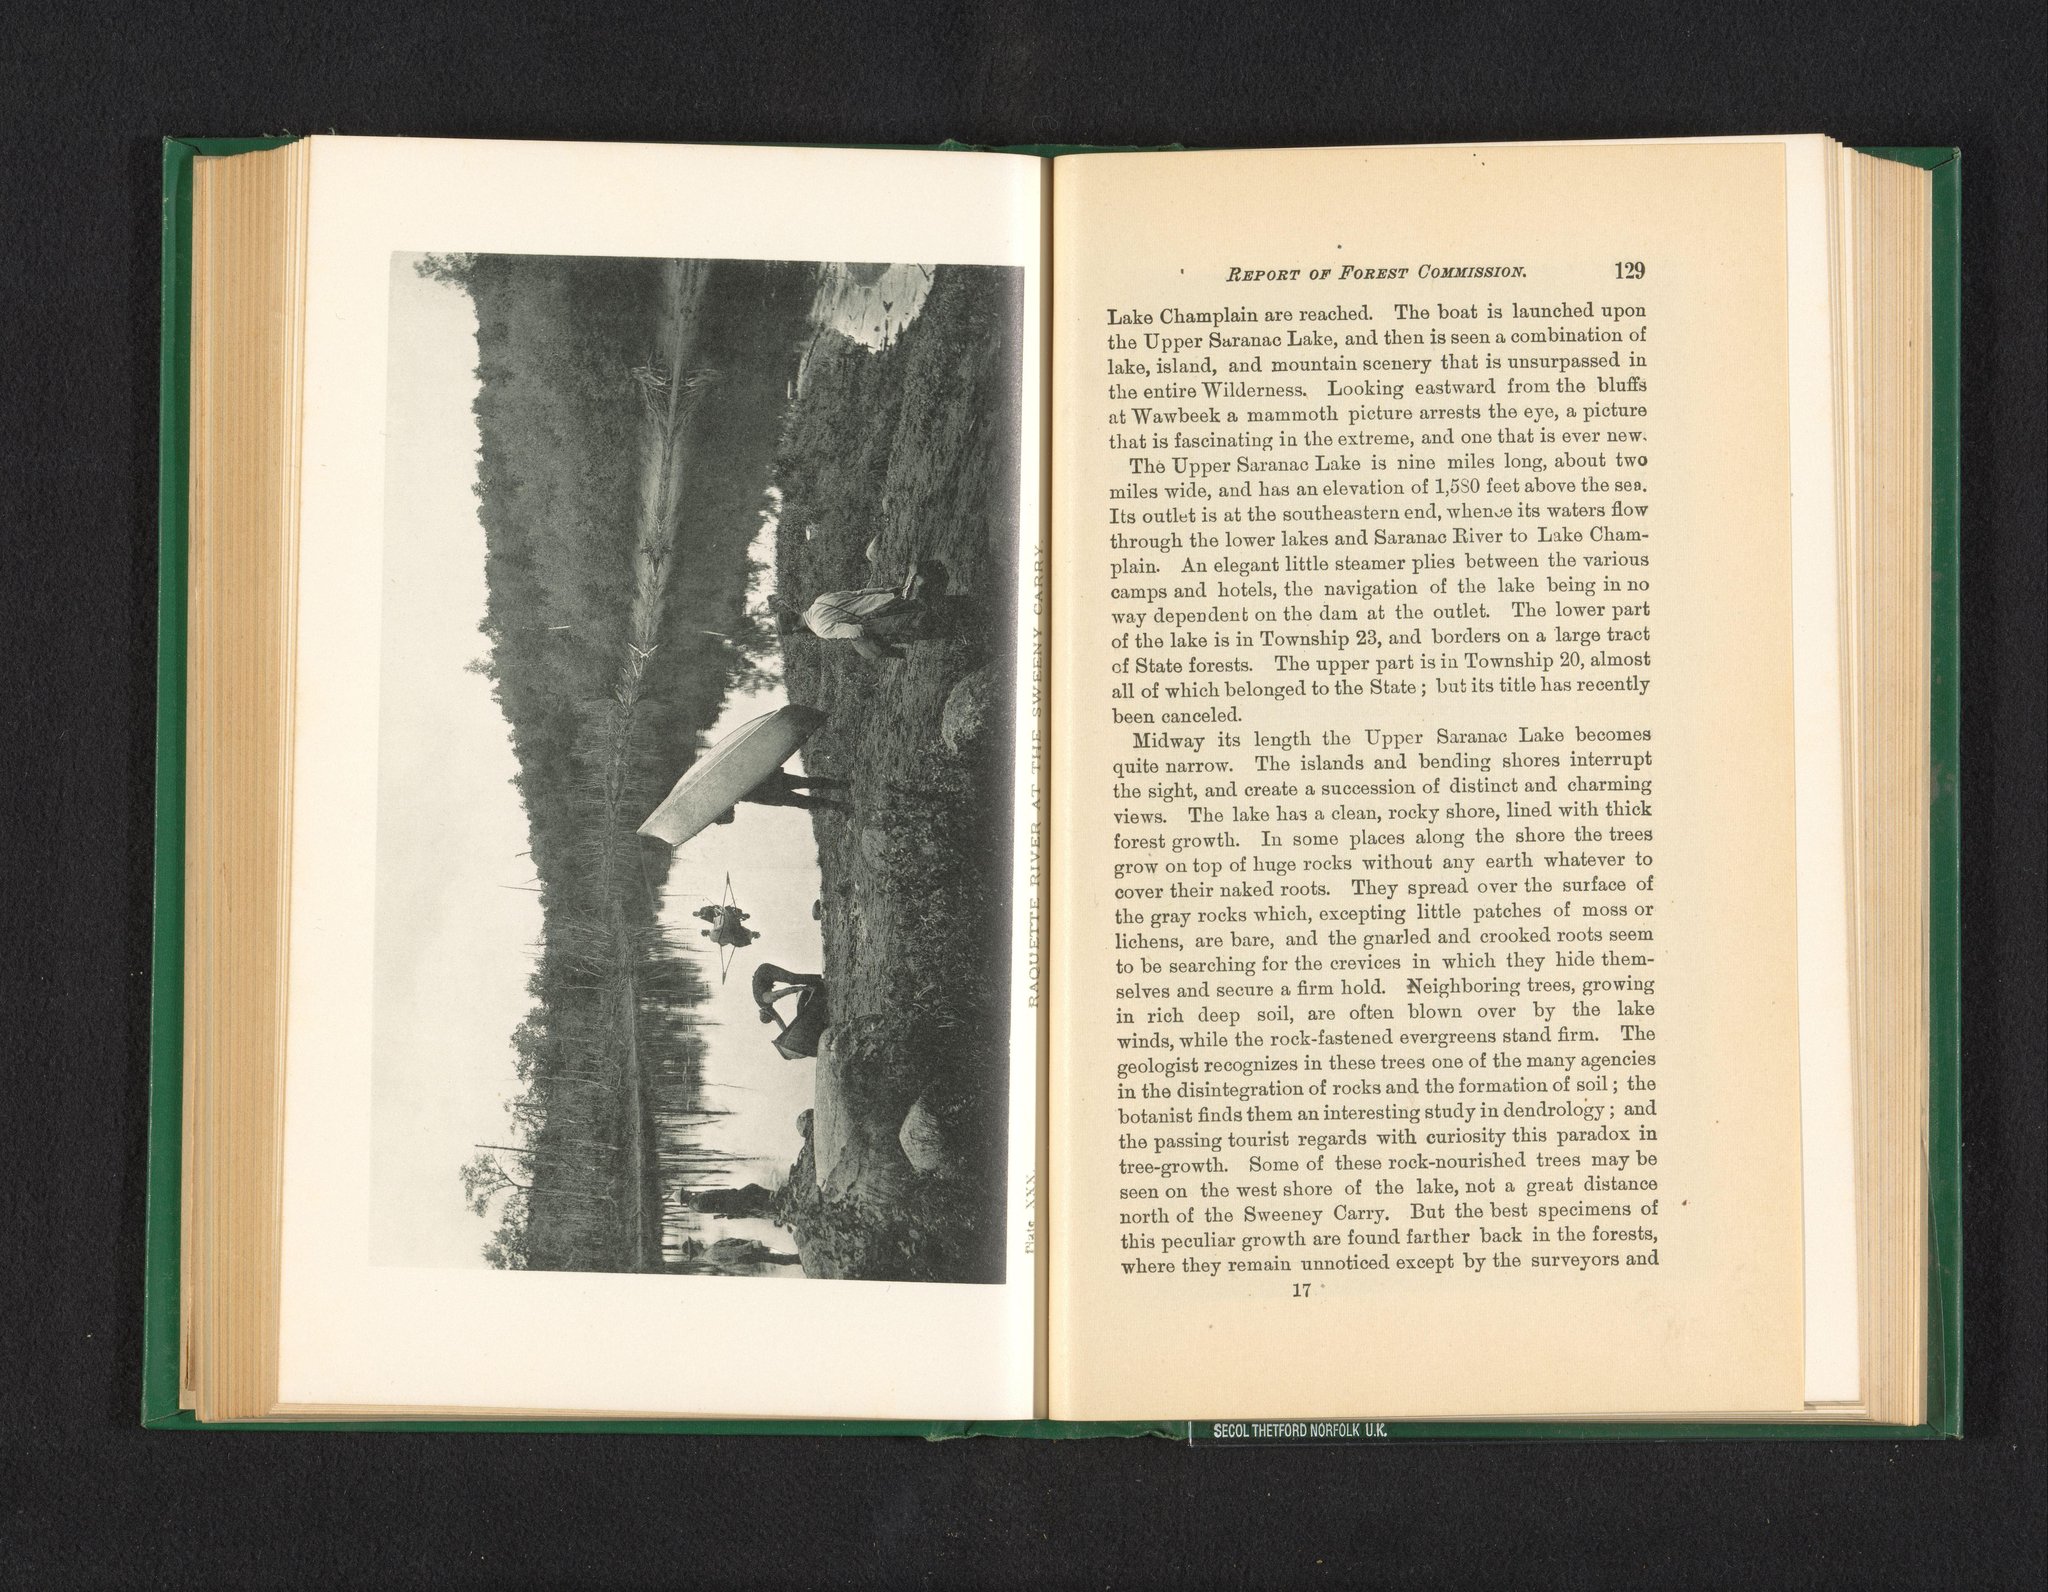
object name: photomechanical print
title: Raquette River at the Sweeny Carry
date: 1891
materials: paper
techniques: photograph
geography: new york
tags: river, rowing-boat, canoe, etc.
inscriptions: number: ‘Plate XXX.’